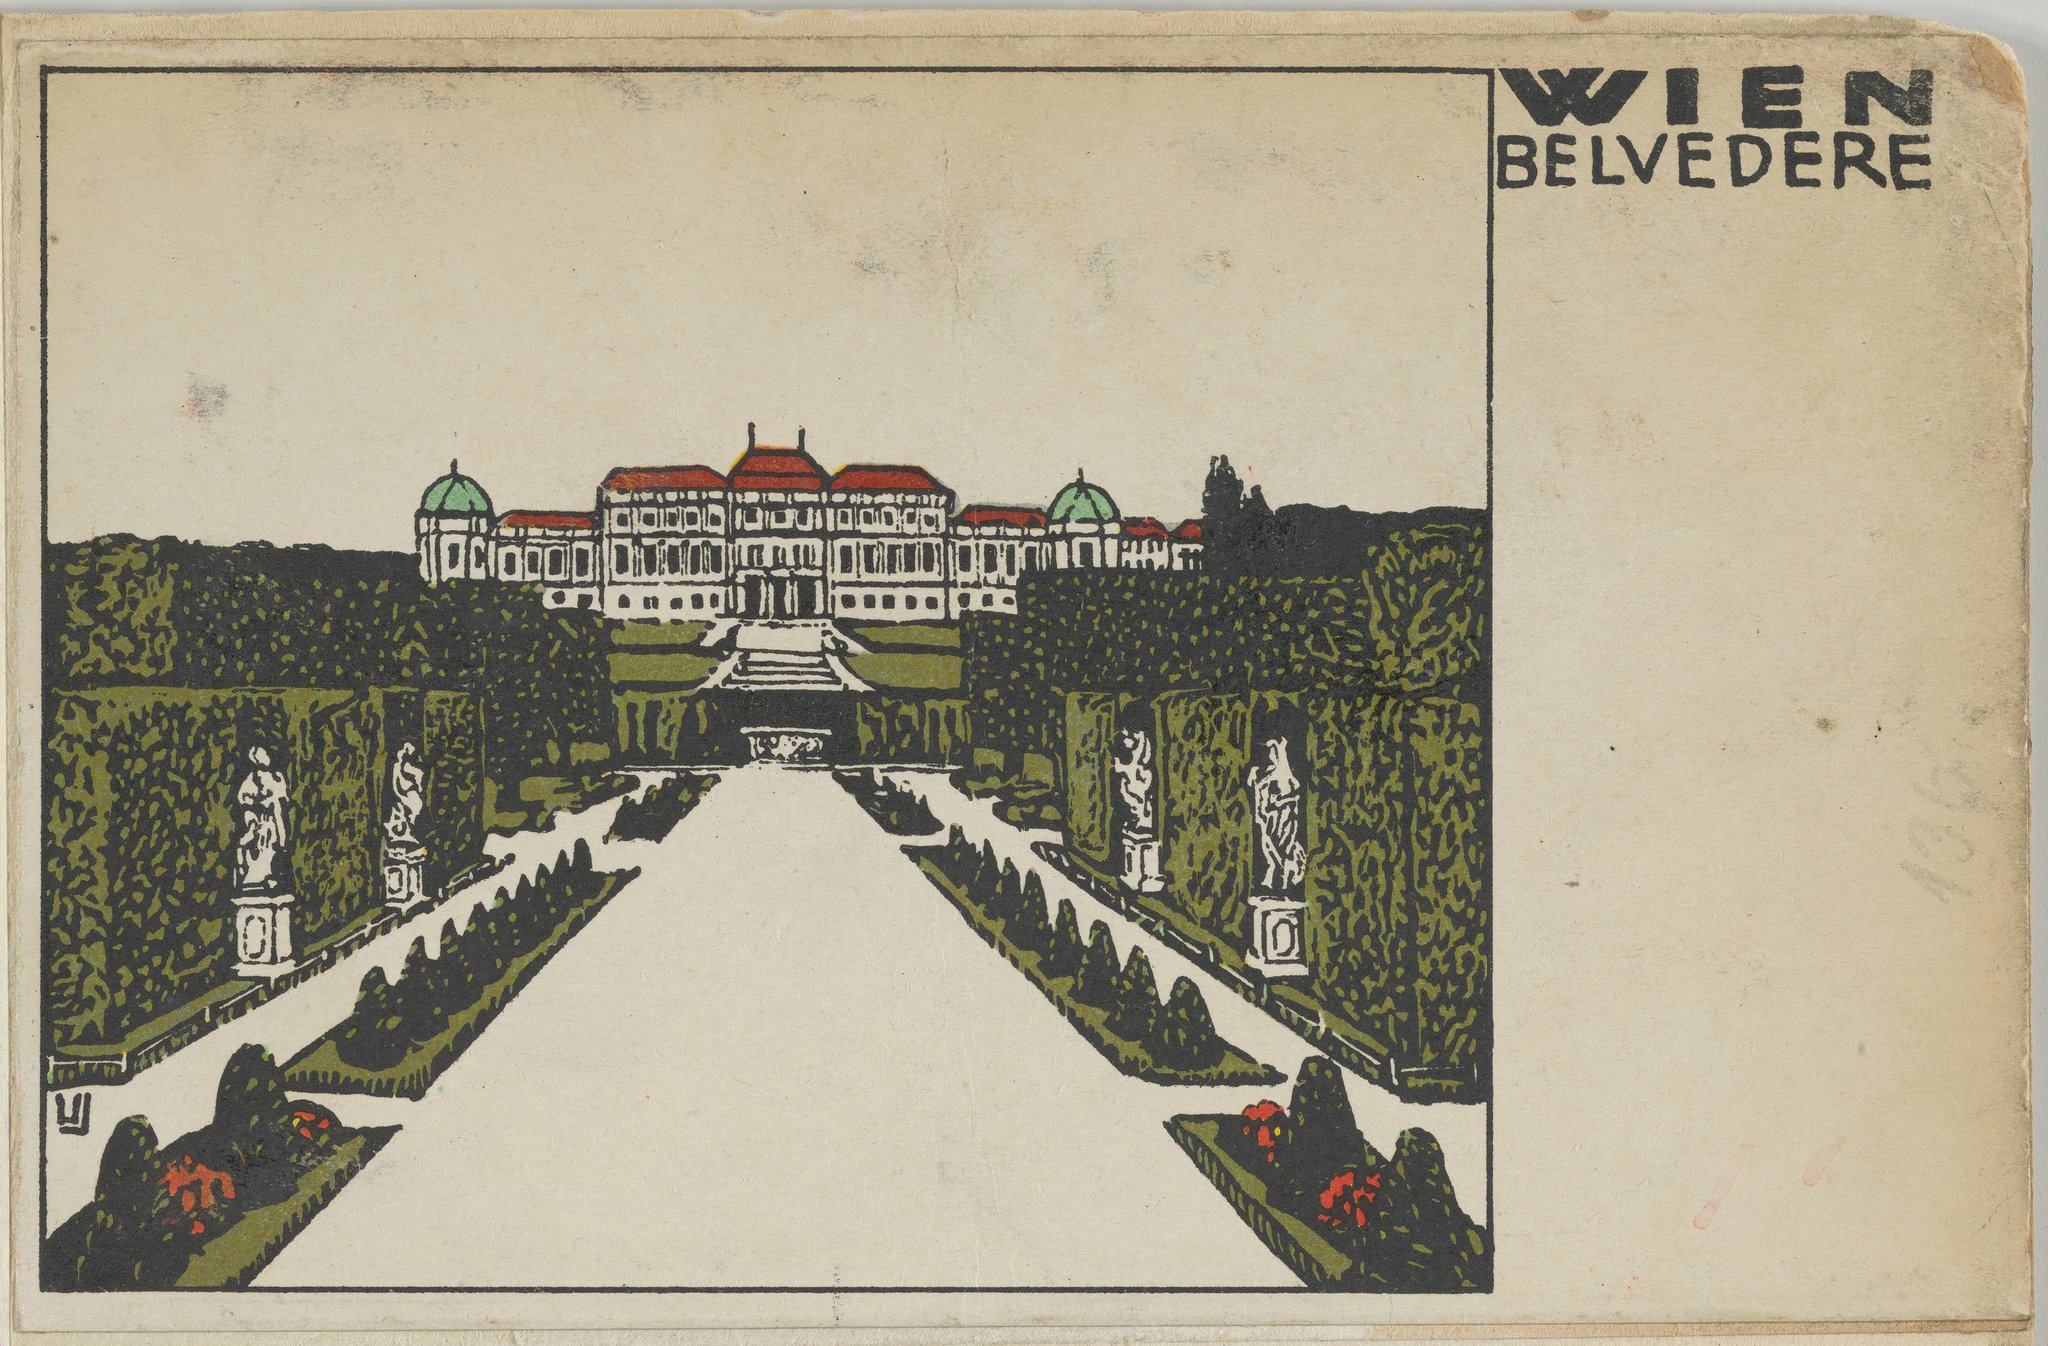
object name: print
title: Vienna: Belvedere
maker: urban janke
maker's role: artist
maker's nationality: austrian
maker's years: 1887-1914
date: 1908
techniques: lithograph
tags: buildings,courtyards